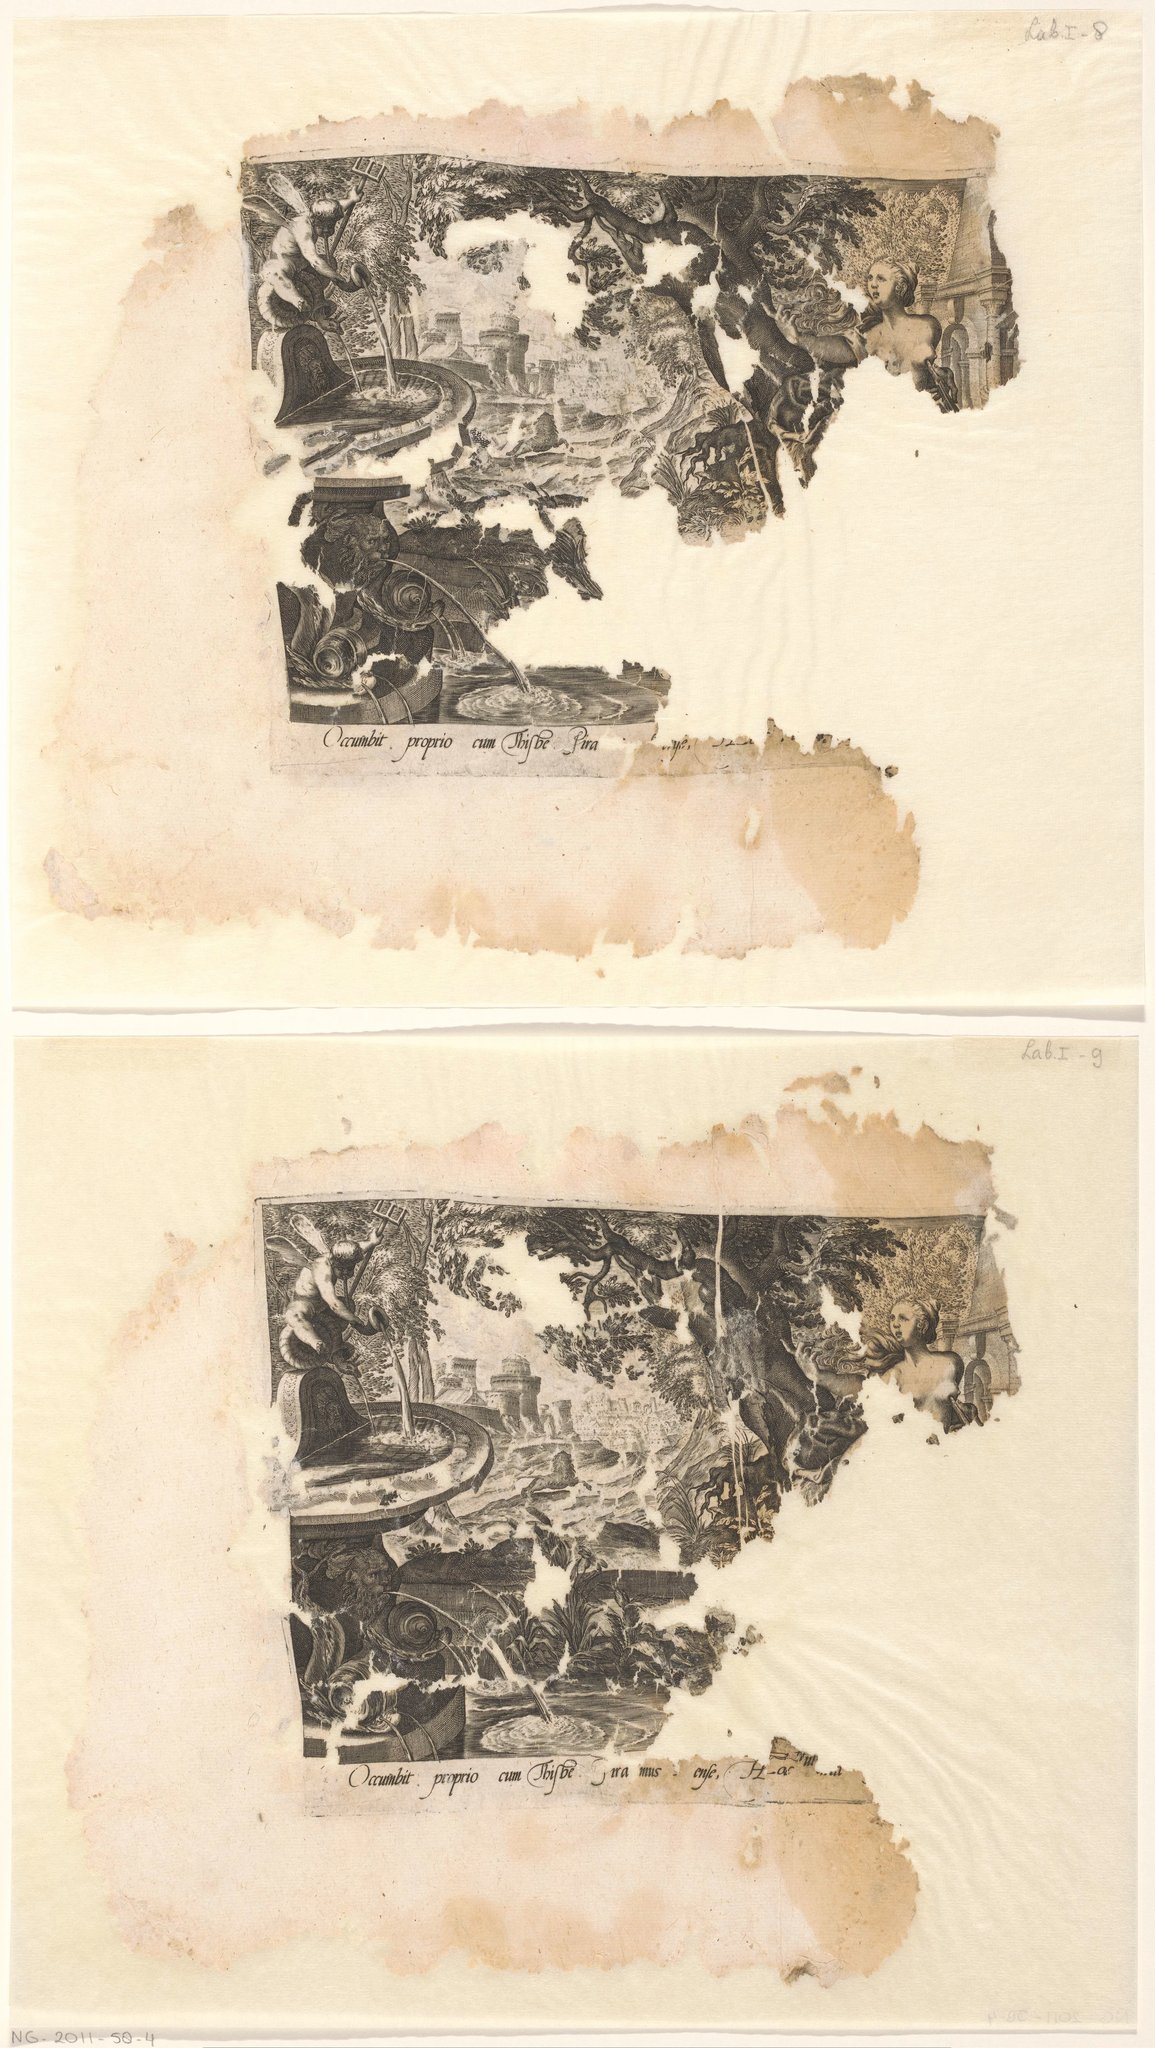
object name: print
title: Pyramus en Thisbe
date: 1580-1596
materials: paper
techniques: engraving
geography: northern netherlands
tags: thisbe kills herself with pyramus' sword (the scene may be represented near a fountain)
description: De prenten in de Nova Zembla collectie zijn tijdens een expeditie van Willem Barendsz en Jacob van Heemskerk in 1596-1597 noodgedwongen in het winterkamp, het ‘Behouden Huis’, op het eiland achtergelaten. De prenten waren in één of meerdere stapels als handelswaar meegenomen vanuit Amsterdam. Bijna drie eeuwen later, in 1871, keerde de Noor Elling Carlsen terug naar Nova Zembla en vond daar de restanten van het ‘Behouden Huis, inclusief een groot deel van de inventaris. Een deel van de prenten, in de vorm van aaneengekoekte kluiten, werd toen ook teruggevonden. De papierkluiten waren soms op meerdere plekken gebroken. Tussen 1975-1979 zijn de prenten van elkaar gescheiden. Dit leverde in totaal ca. 1000 fragmenten van ca. 400 afdrukken van ca. 150 verschillende prenten op. Voor zover mogelijk zijn de fragmenten samengevoegd en zijn de prenten gereconstrueerd.